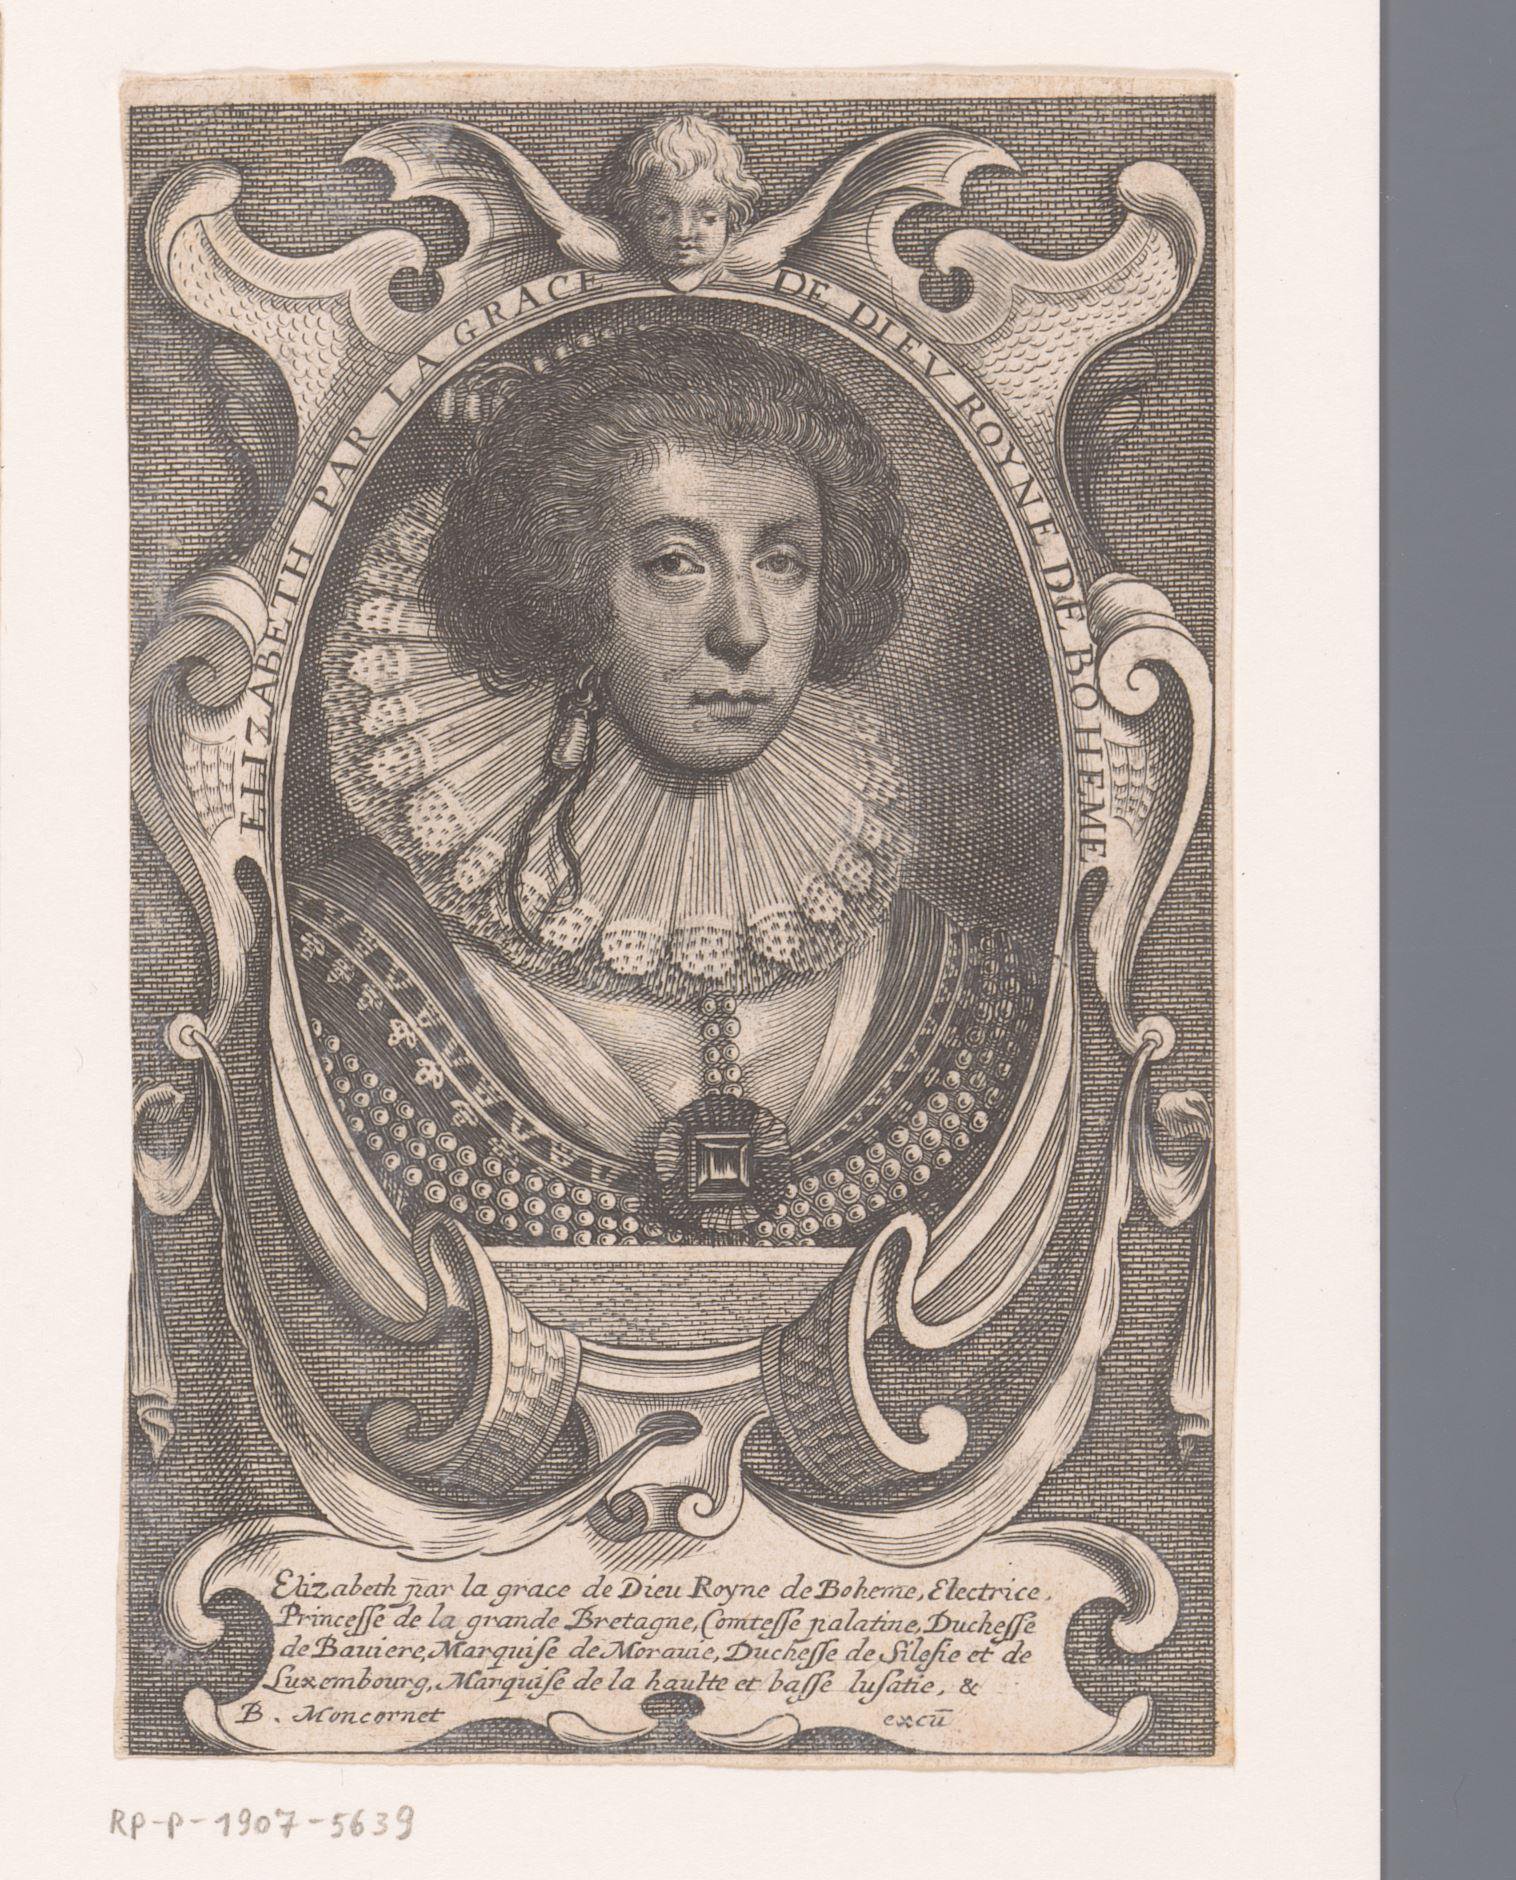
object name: print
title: Portret van Elisabeth van de Palts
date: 1638-1668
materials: paper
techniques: engraving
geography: paris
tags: historical persons - bb - woman, princess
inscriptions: collector's mark: Lugt 2228